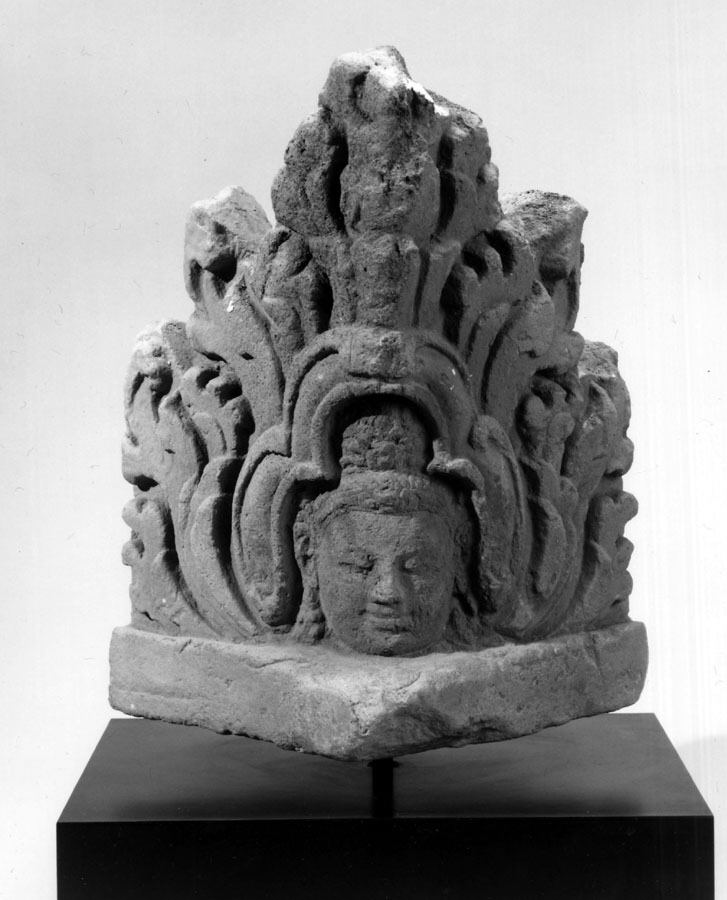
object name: antefix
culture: indonesian, javanese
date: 801-900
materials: terracotta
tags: heads